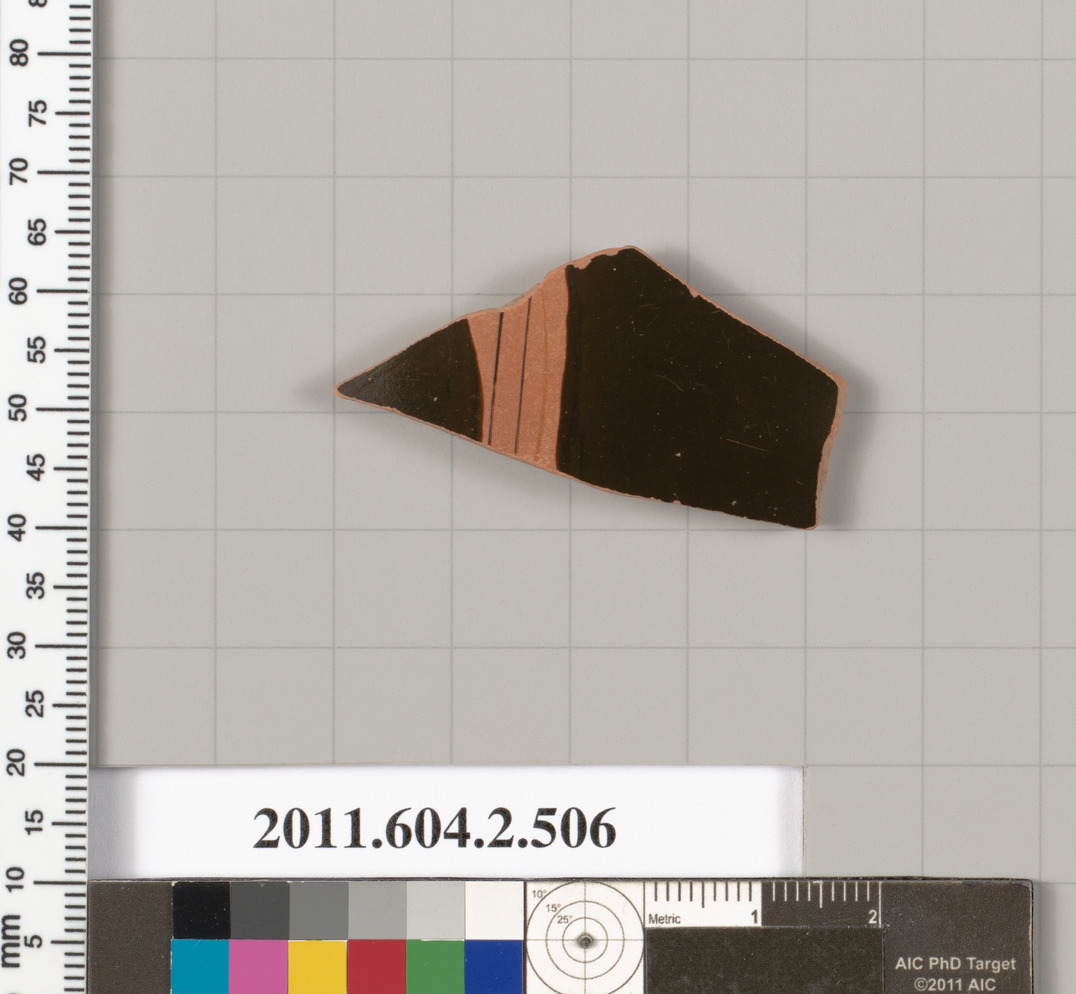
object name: column krater fragment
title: Terracotta fragment of a column-krater (bowl for mixing wine and water)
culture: greek, attic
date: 450-430 BCE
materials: terracotta